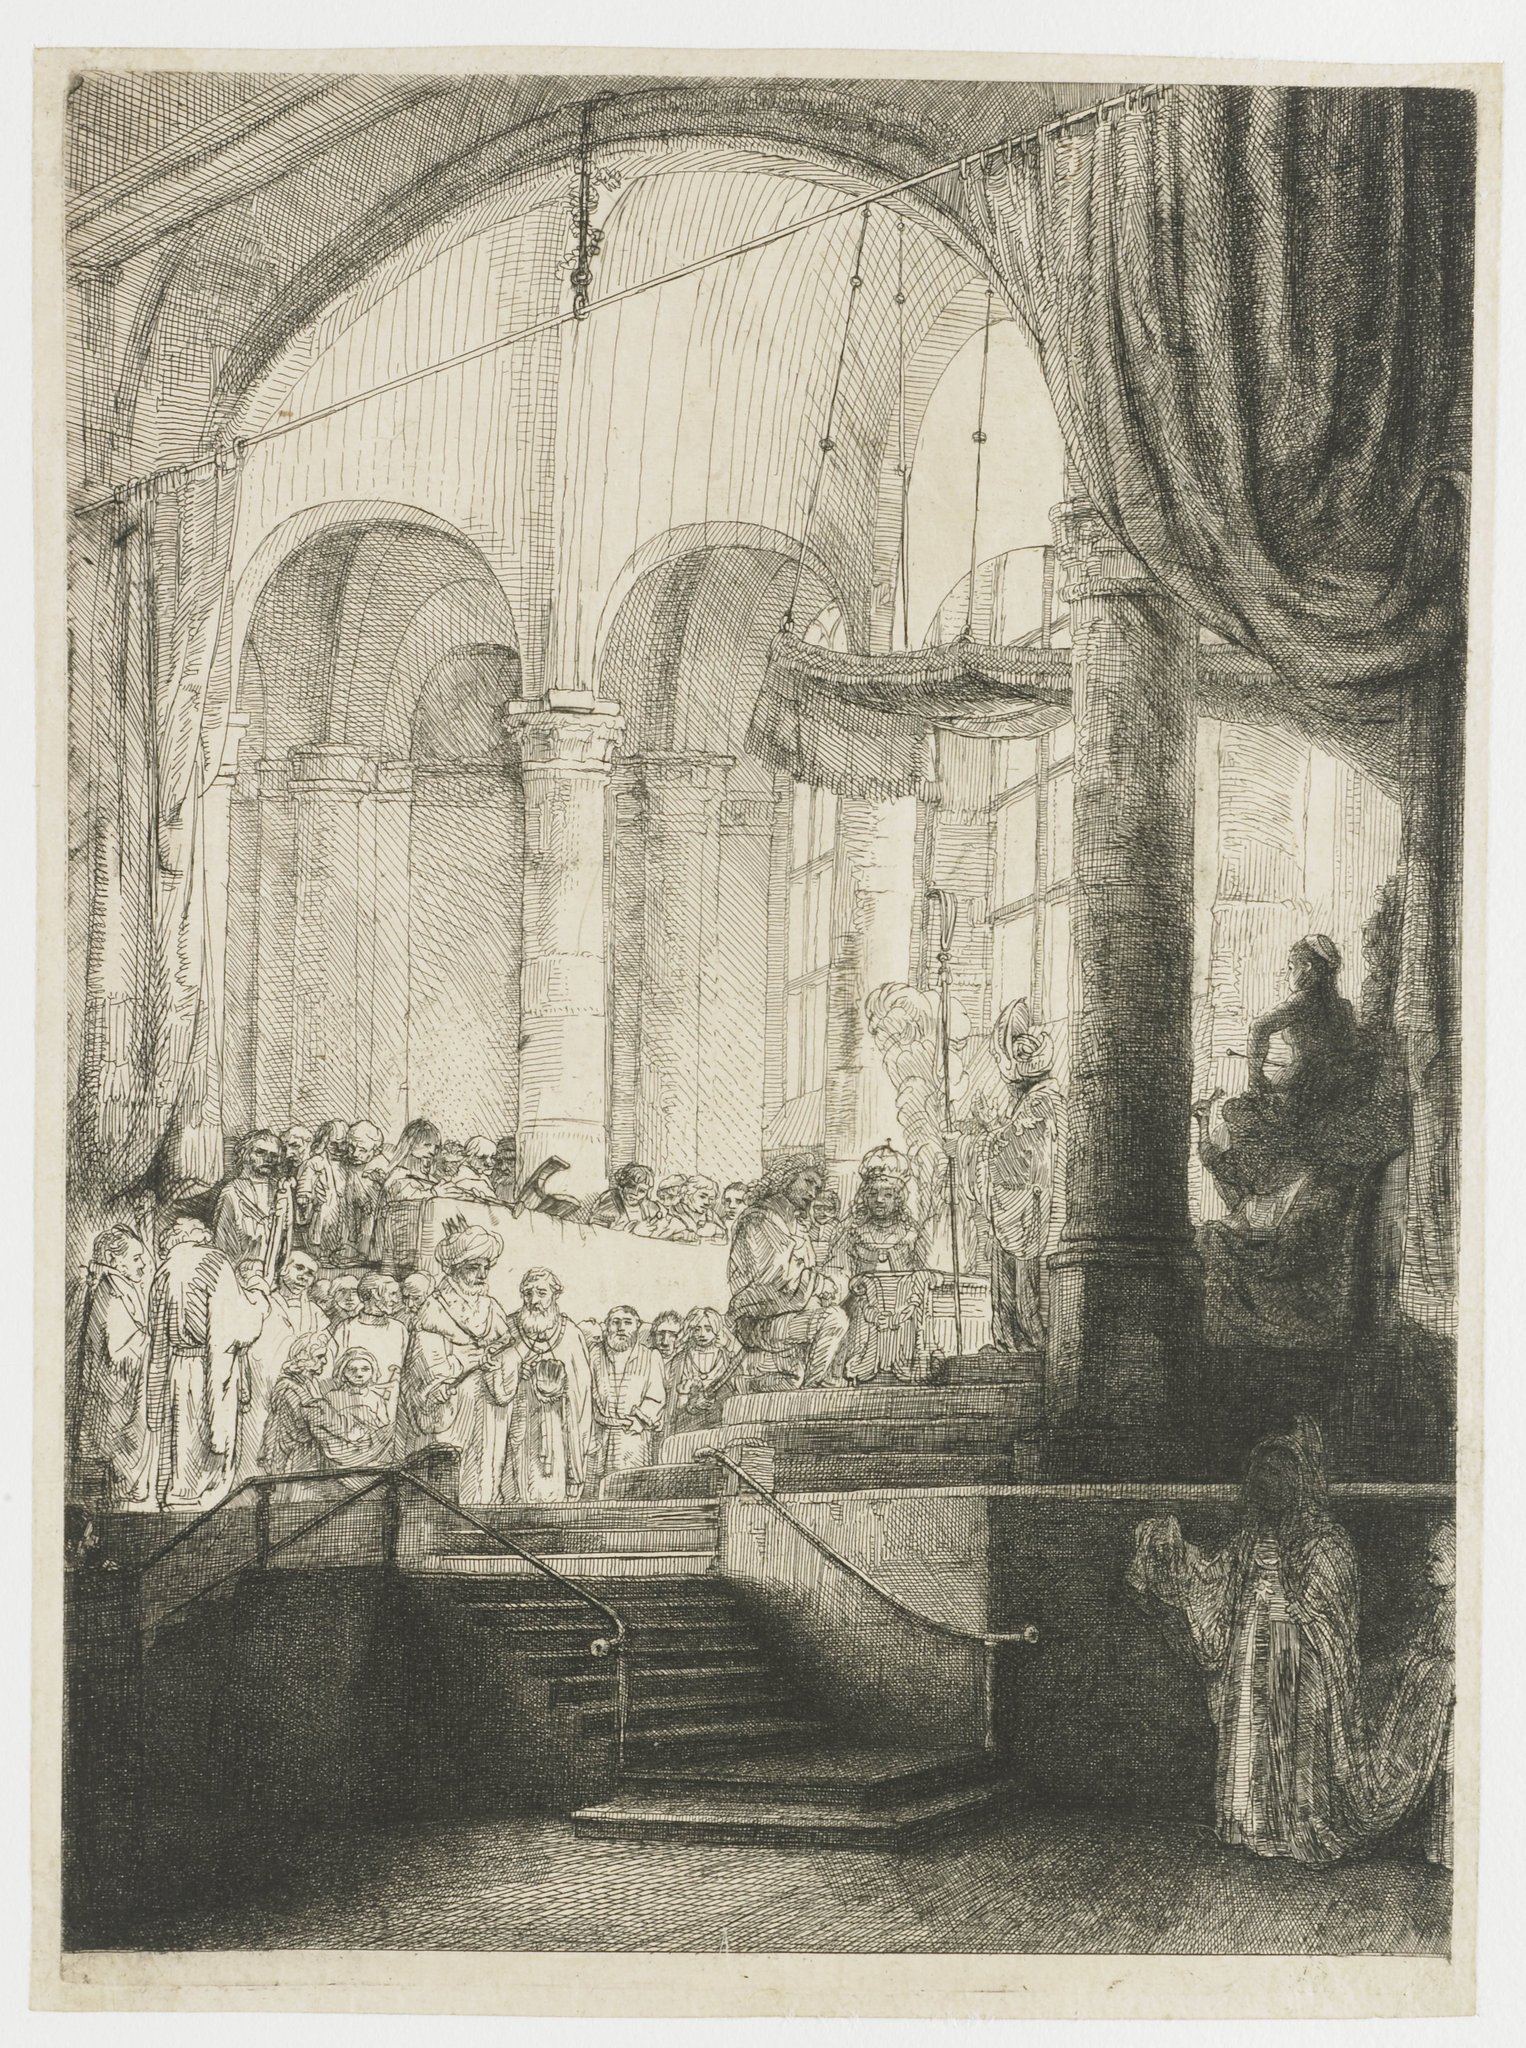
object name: print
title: Medea: or the marriage of Jason and Creusa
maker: rembrandt van rijn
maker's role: draughtsman, painter, print maker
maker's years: 1606-1669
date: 1648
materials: paper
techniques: drypoint, etching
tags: marriage of jason and creusa (glauce); possibly with medea watching the scene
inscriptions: collector's mark: Lugt 2773, collector's mark: Lugt 2228